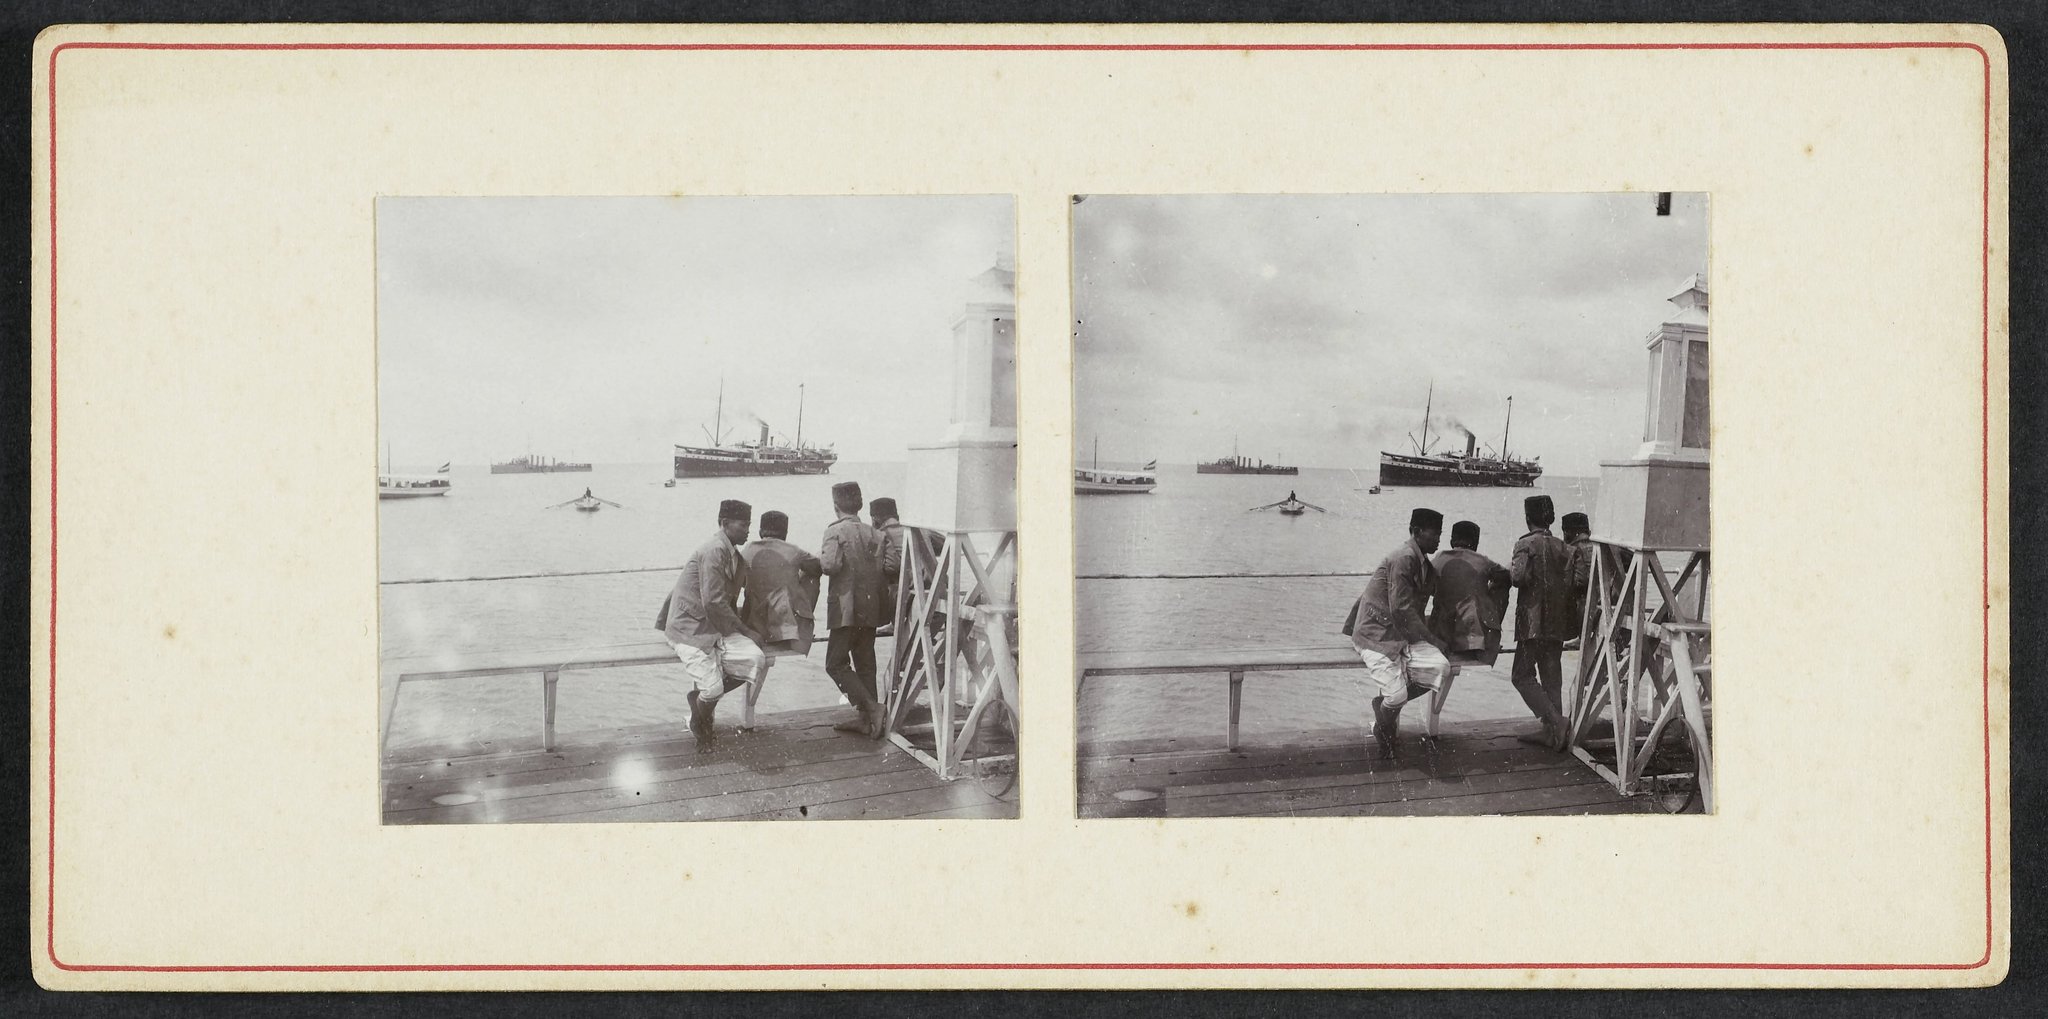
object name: stereograph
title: In de haven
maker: robert julius boers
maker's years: 1867-1932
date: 1900-1922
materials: cardboard, photographic support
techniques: gelatin silver print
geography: bangka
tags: robert julius boers, dutch east indies, the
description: Indische jongens op een steiger kijken naar schepen in de haven. Onderdeel van een groep stereofoto's van Robert Julius Boers, chef van het staatsbedrijf de Banka-tinwinning op Banka, uit de periode ca. 1900-1922.